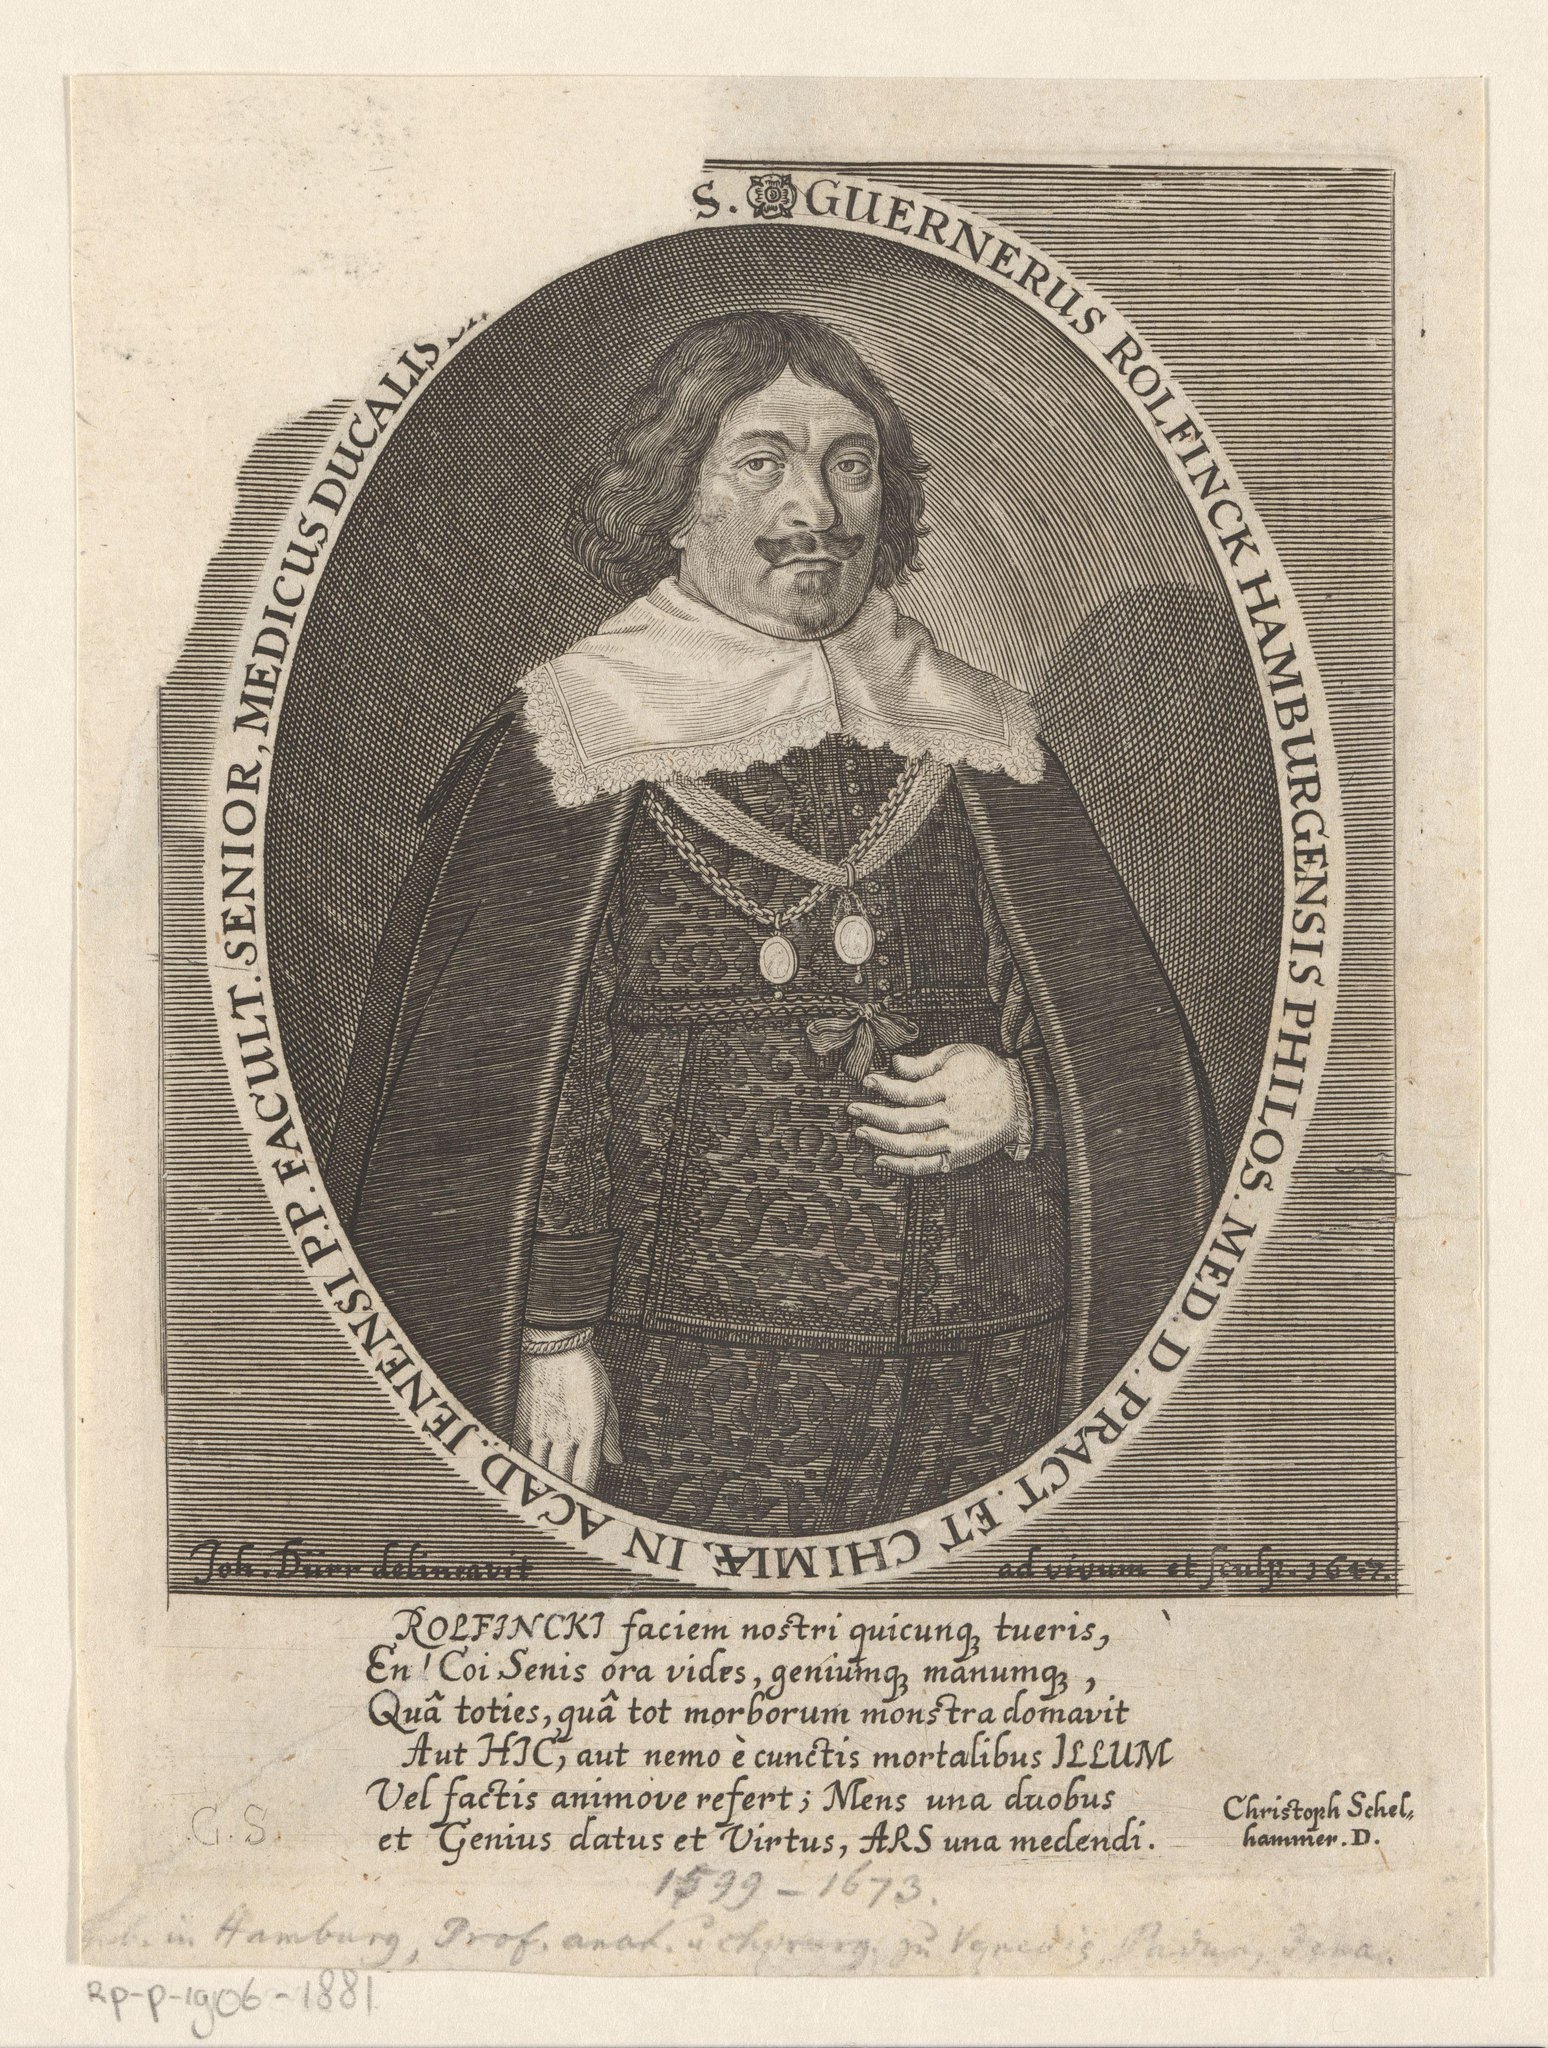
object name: print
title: Portret van Werner Rolfink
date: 1647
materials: paper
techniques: engraving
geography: weimar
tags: historical persons, pendant, trinket, 'breloque'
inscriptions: collector's mark: Lugt 2228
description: Groot deel van de linkerbovenhoek is afgescheurd.